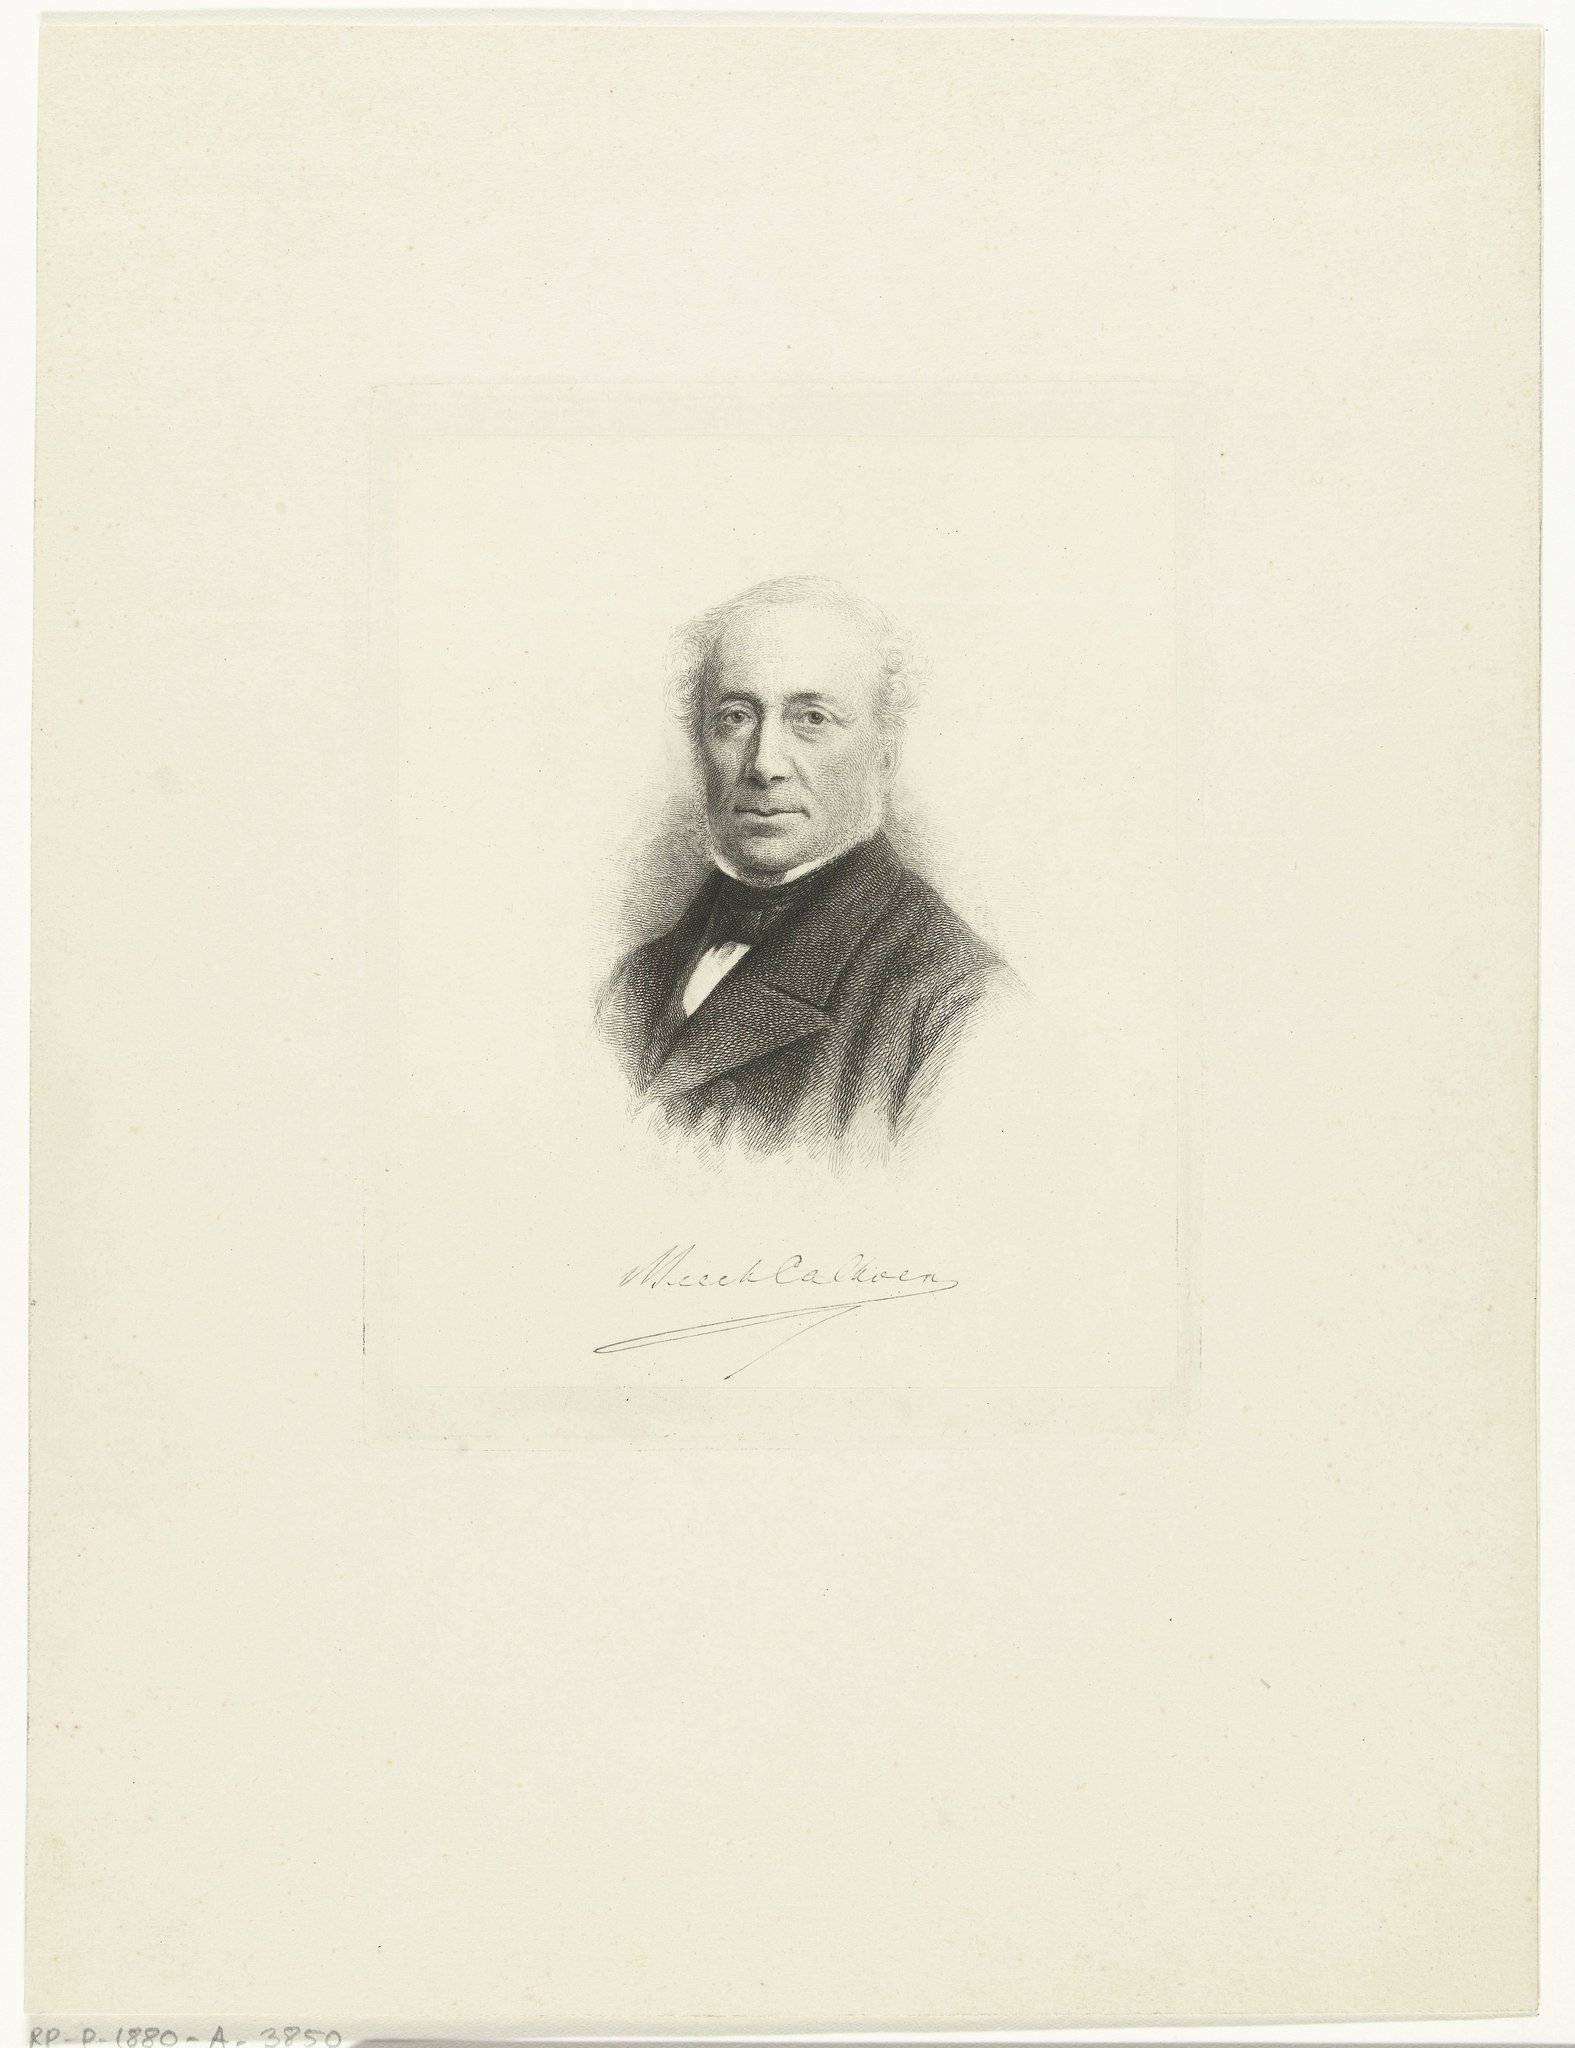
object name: print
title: Portret van Aarnoud Jan van Beeck Calkoen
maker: johannes arnoldus boland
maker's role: print maker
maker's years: 1838-1922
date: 1860-1880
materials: paper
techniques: etching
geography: amsterdam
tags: leiden, utrecht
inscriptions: collector's mark: Lugt 2228